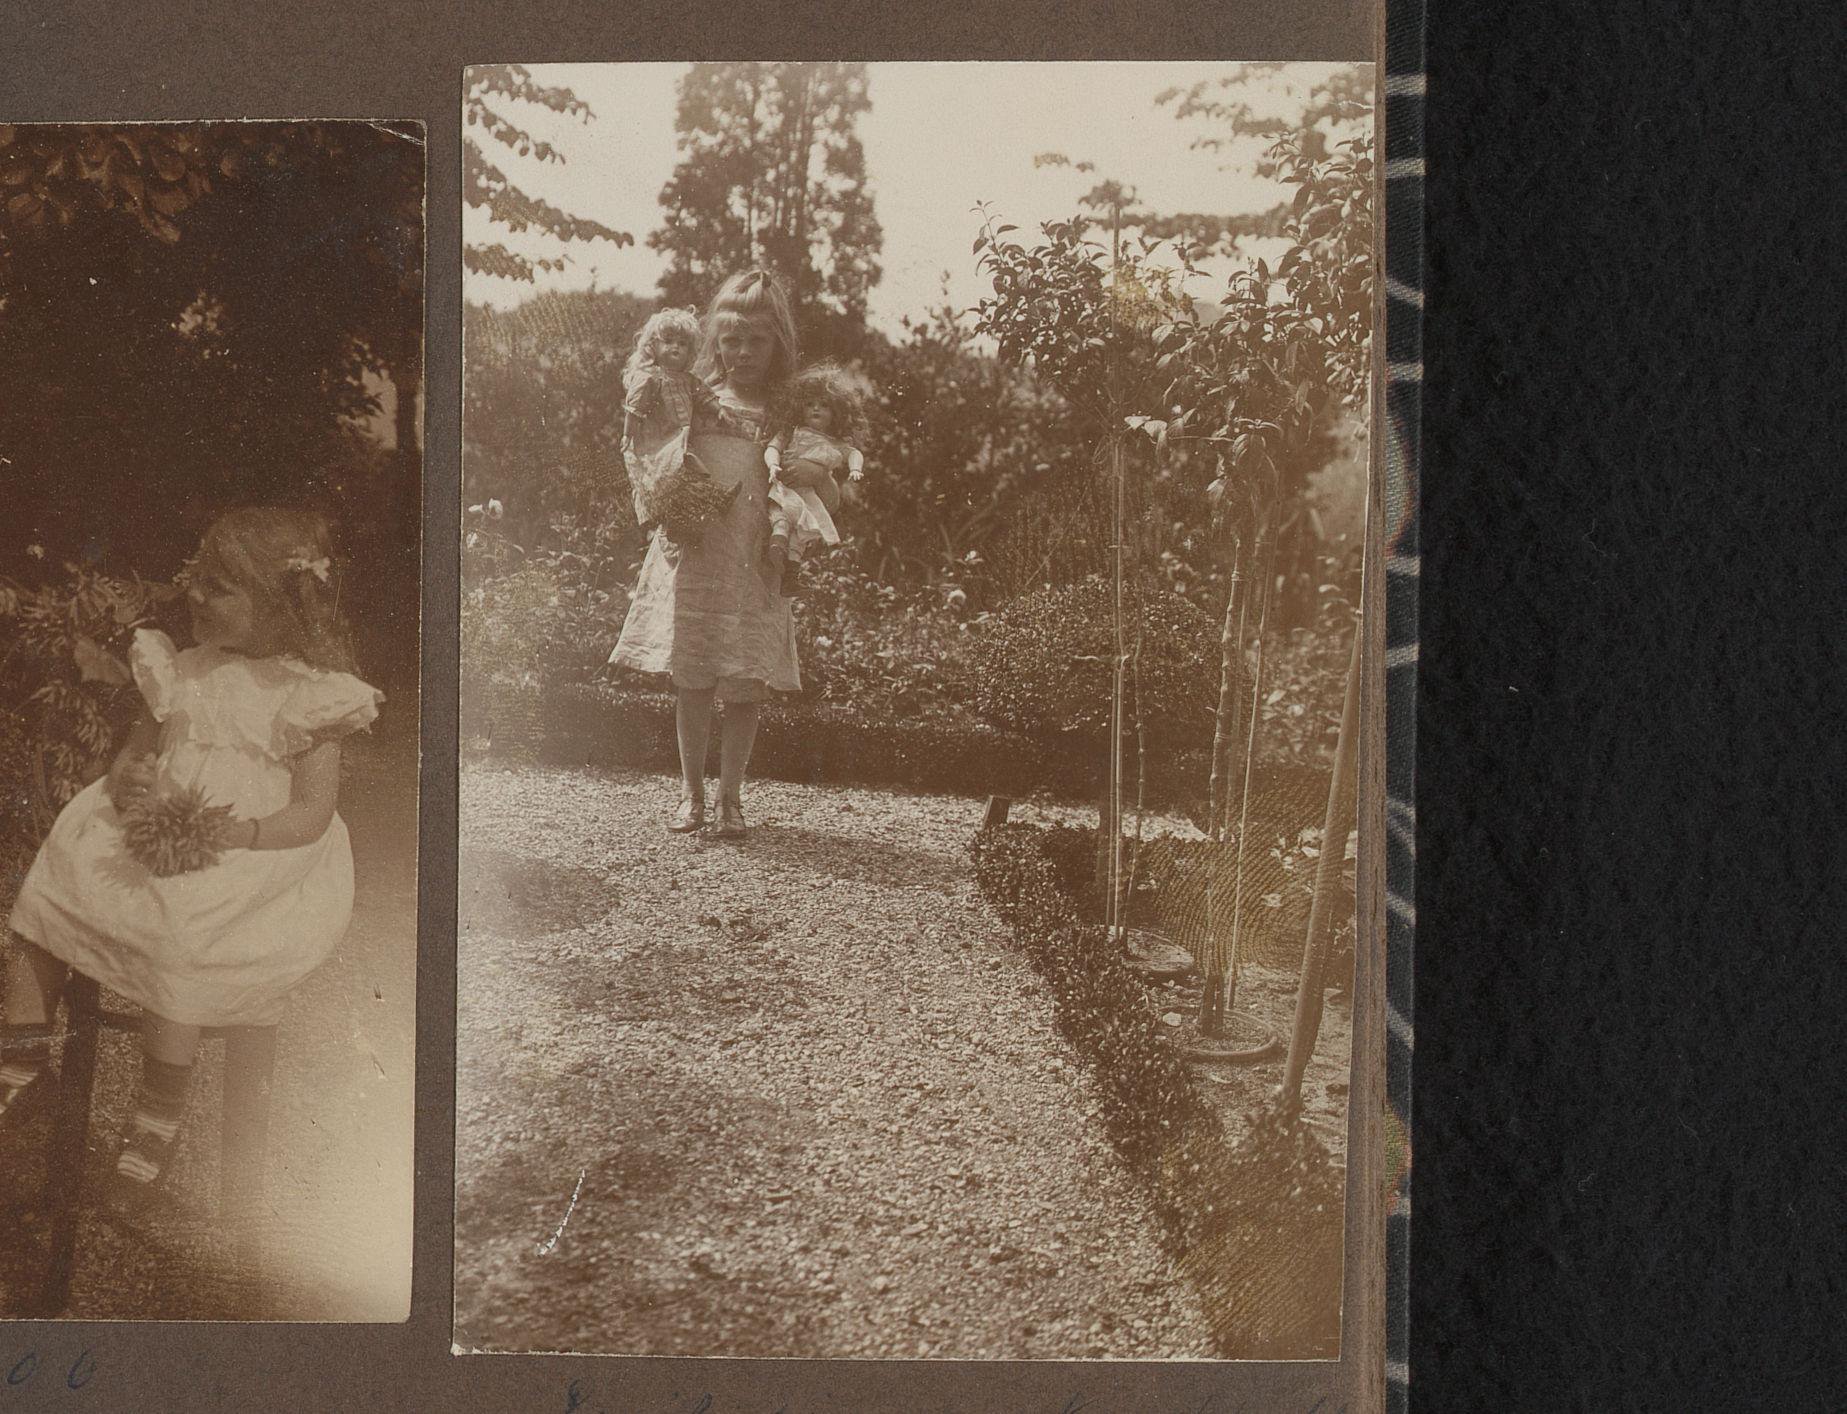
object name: photograph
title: Emilie van Kerckhoff staand in een tuin met twee poppen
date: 1870-1906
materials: paper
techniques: collodion silver print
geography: netherlands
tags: draughtsman, historical persons - bb - woman, girl (child between toddler and youth), (playing with) dolls, netherlands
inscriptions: inscription: ‘Emilietje van Kerckhoff.’